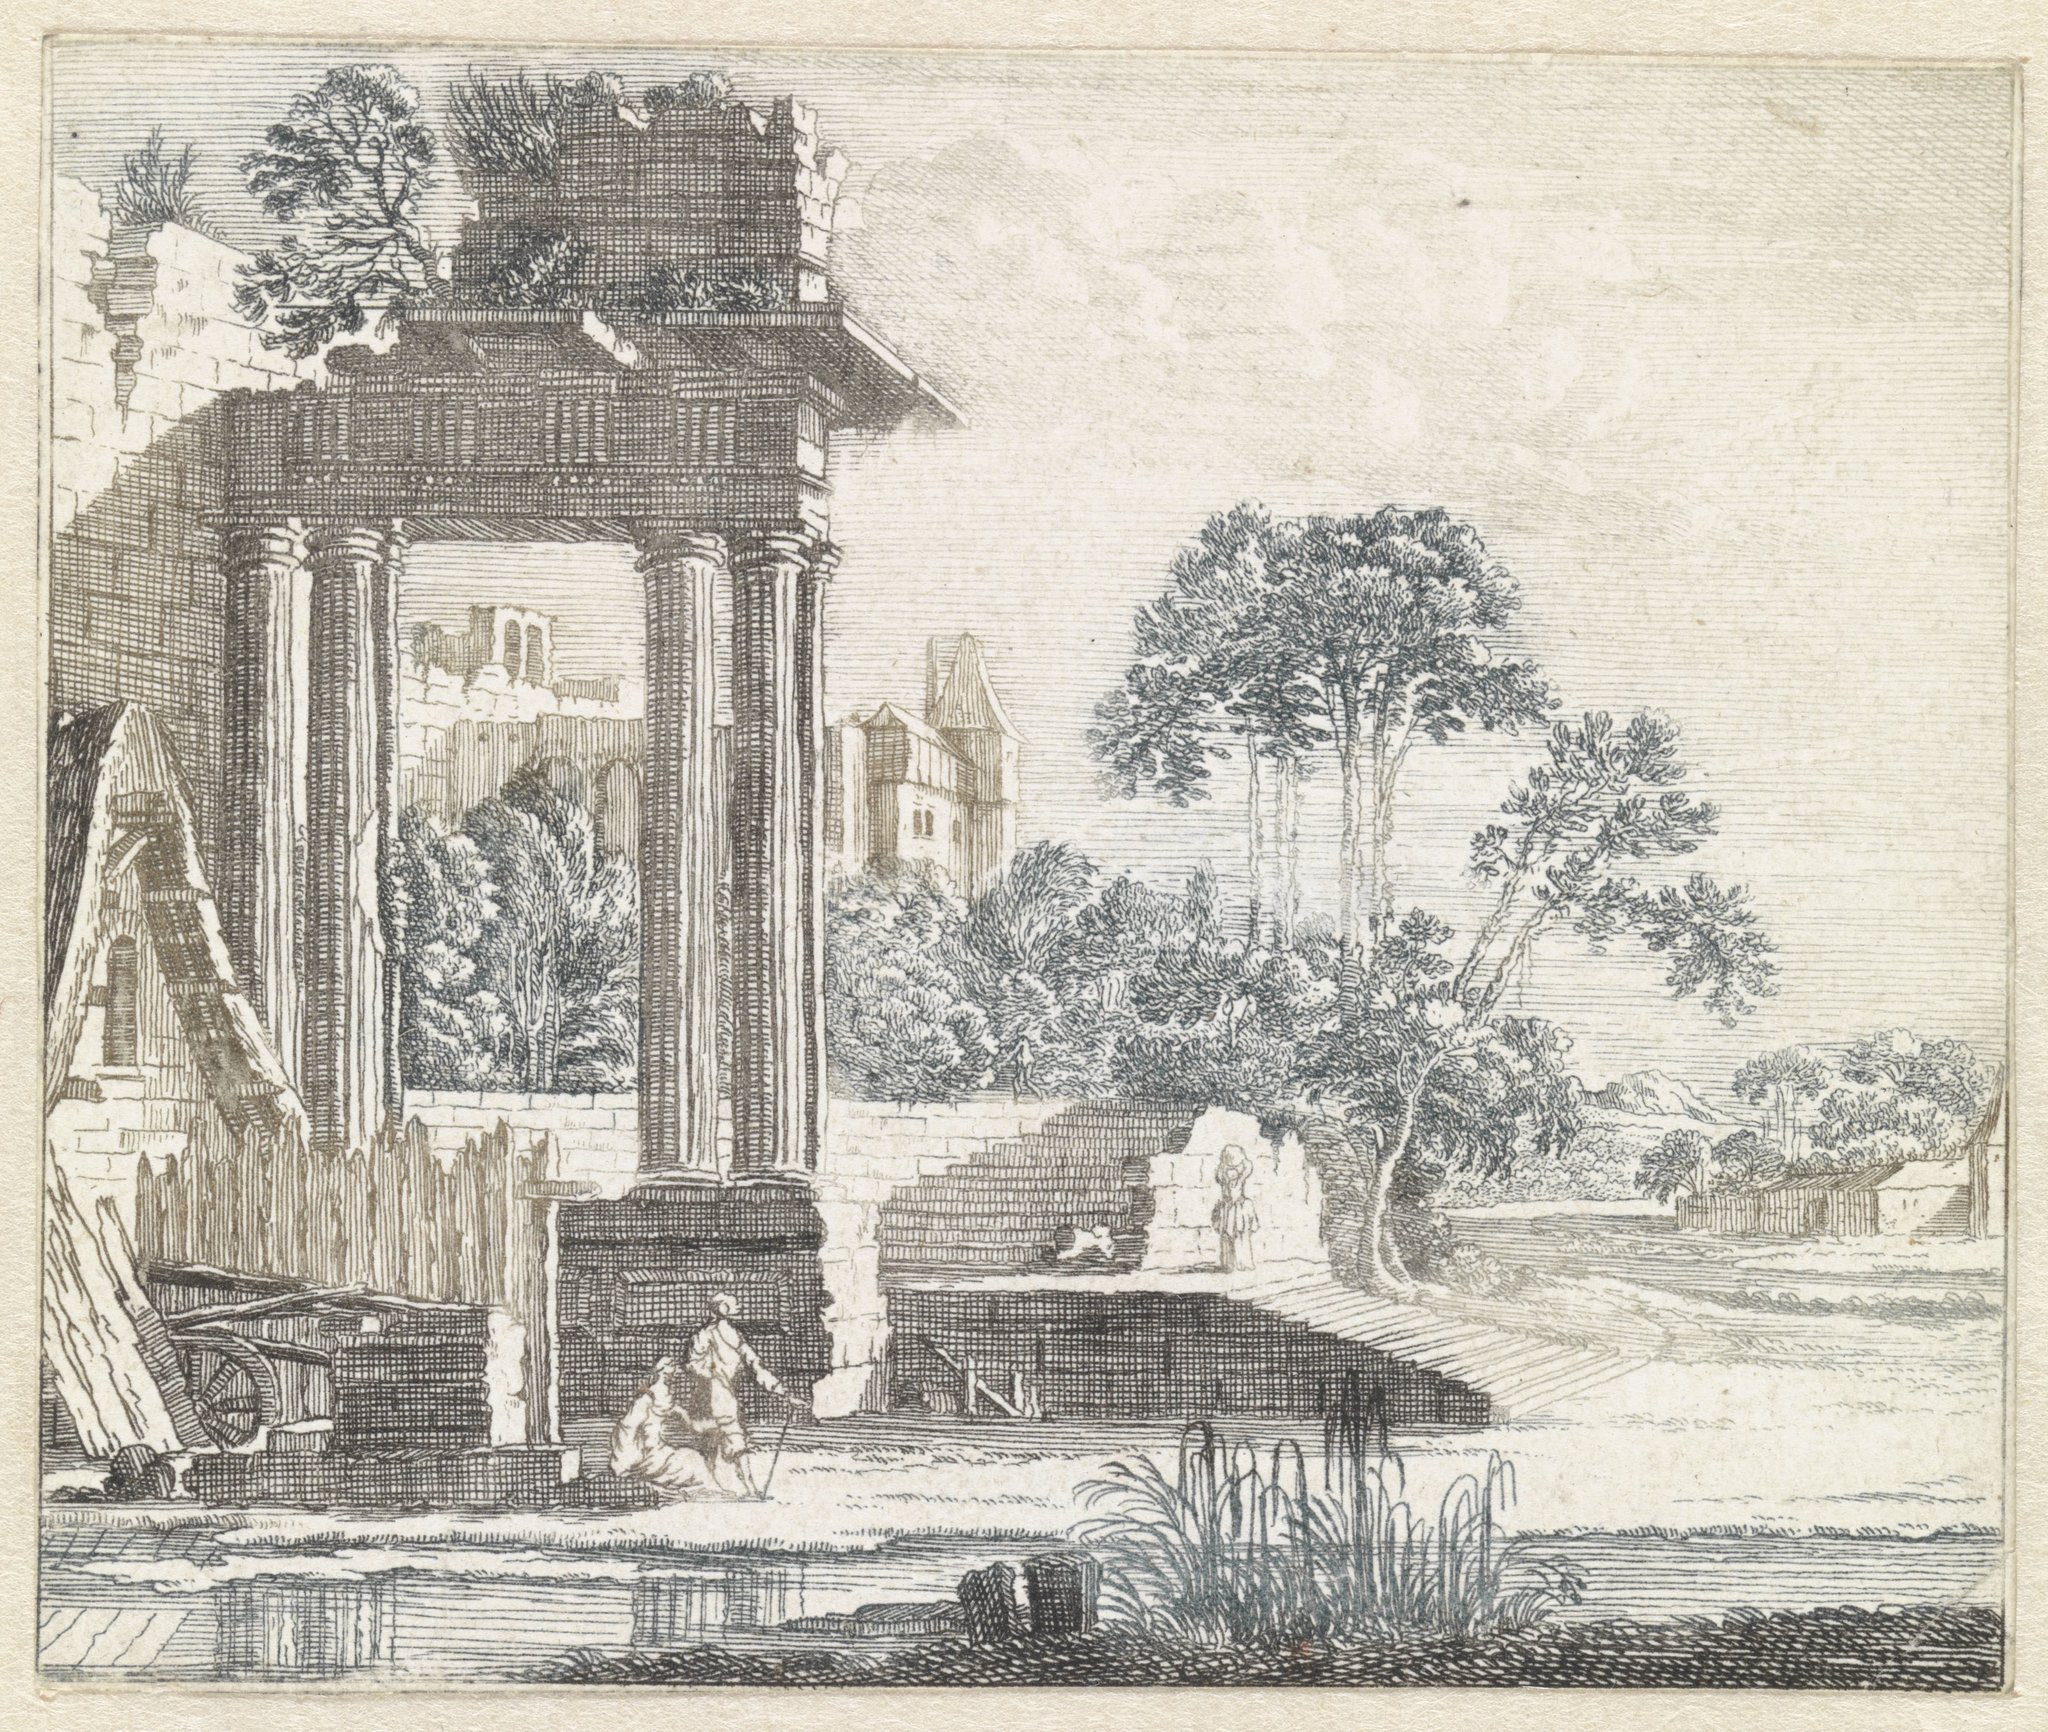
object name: print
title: Landschap met klassieke ruïnes langs het water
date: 1688-1698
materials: paper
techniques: etching, lithography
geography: netherlands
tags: landscape with ruins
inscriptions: collector's mark: Lugt 2228, collector's mark: Lugt 2760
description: Landschap met een ruïne van een Romeinse tempel links en water op de voorgrond.